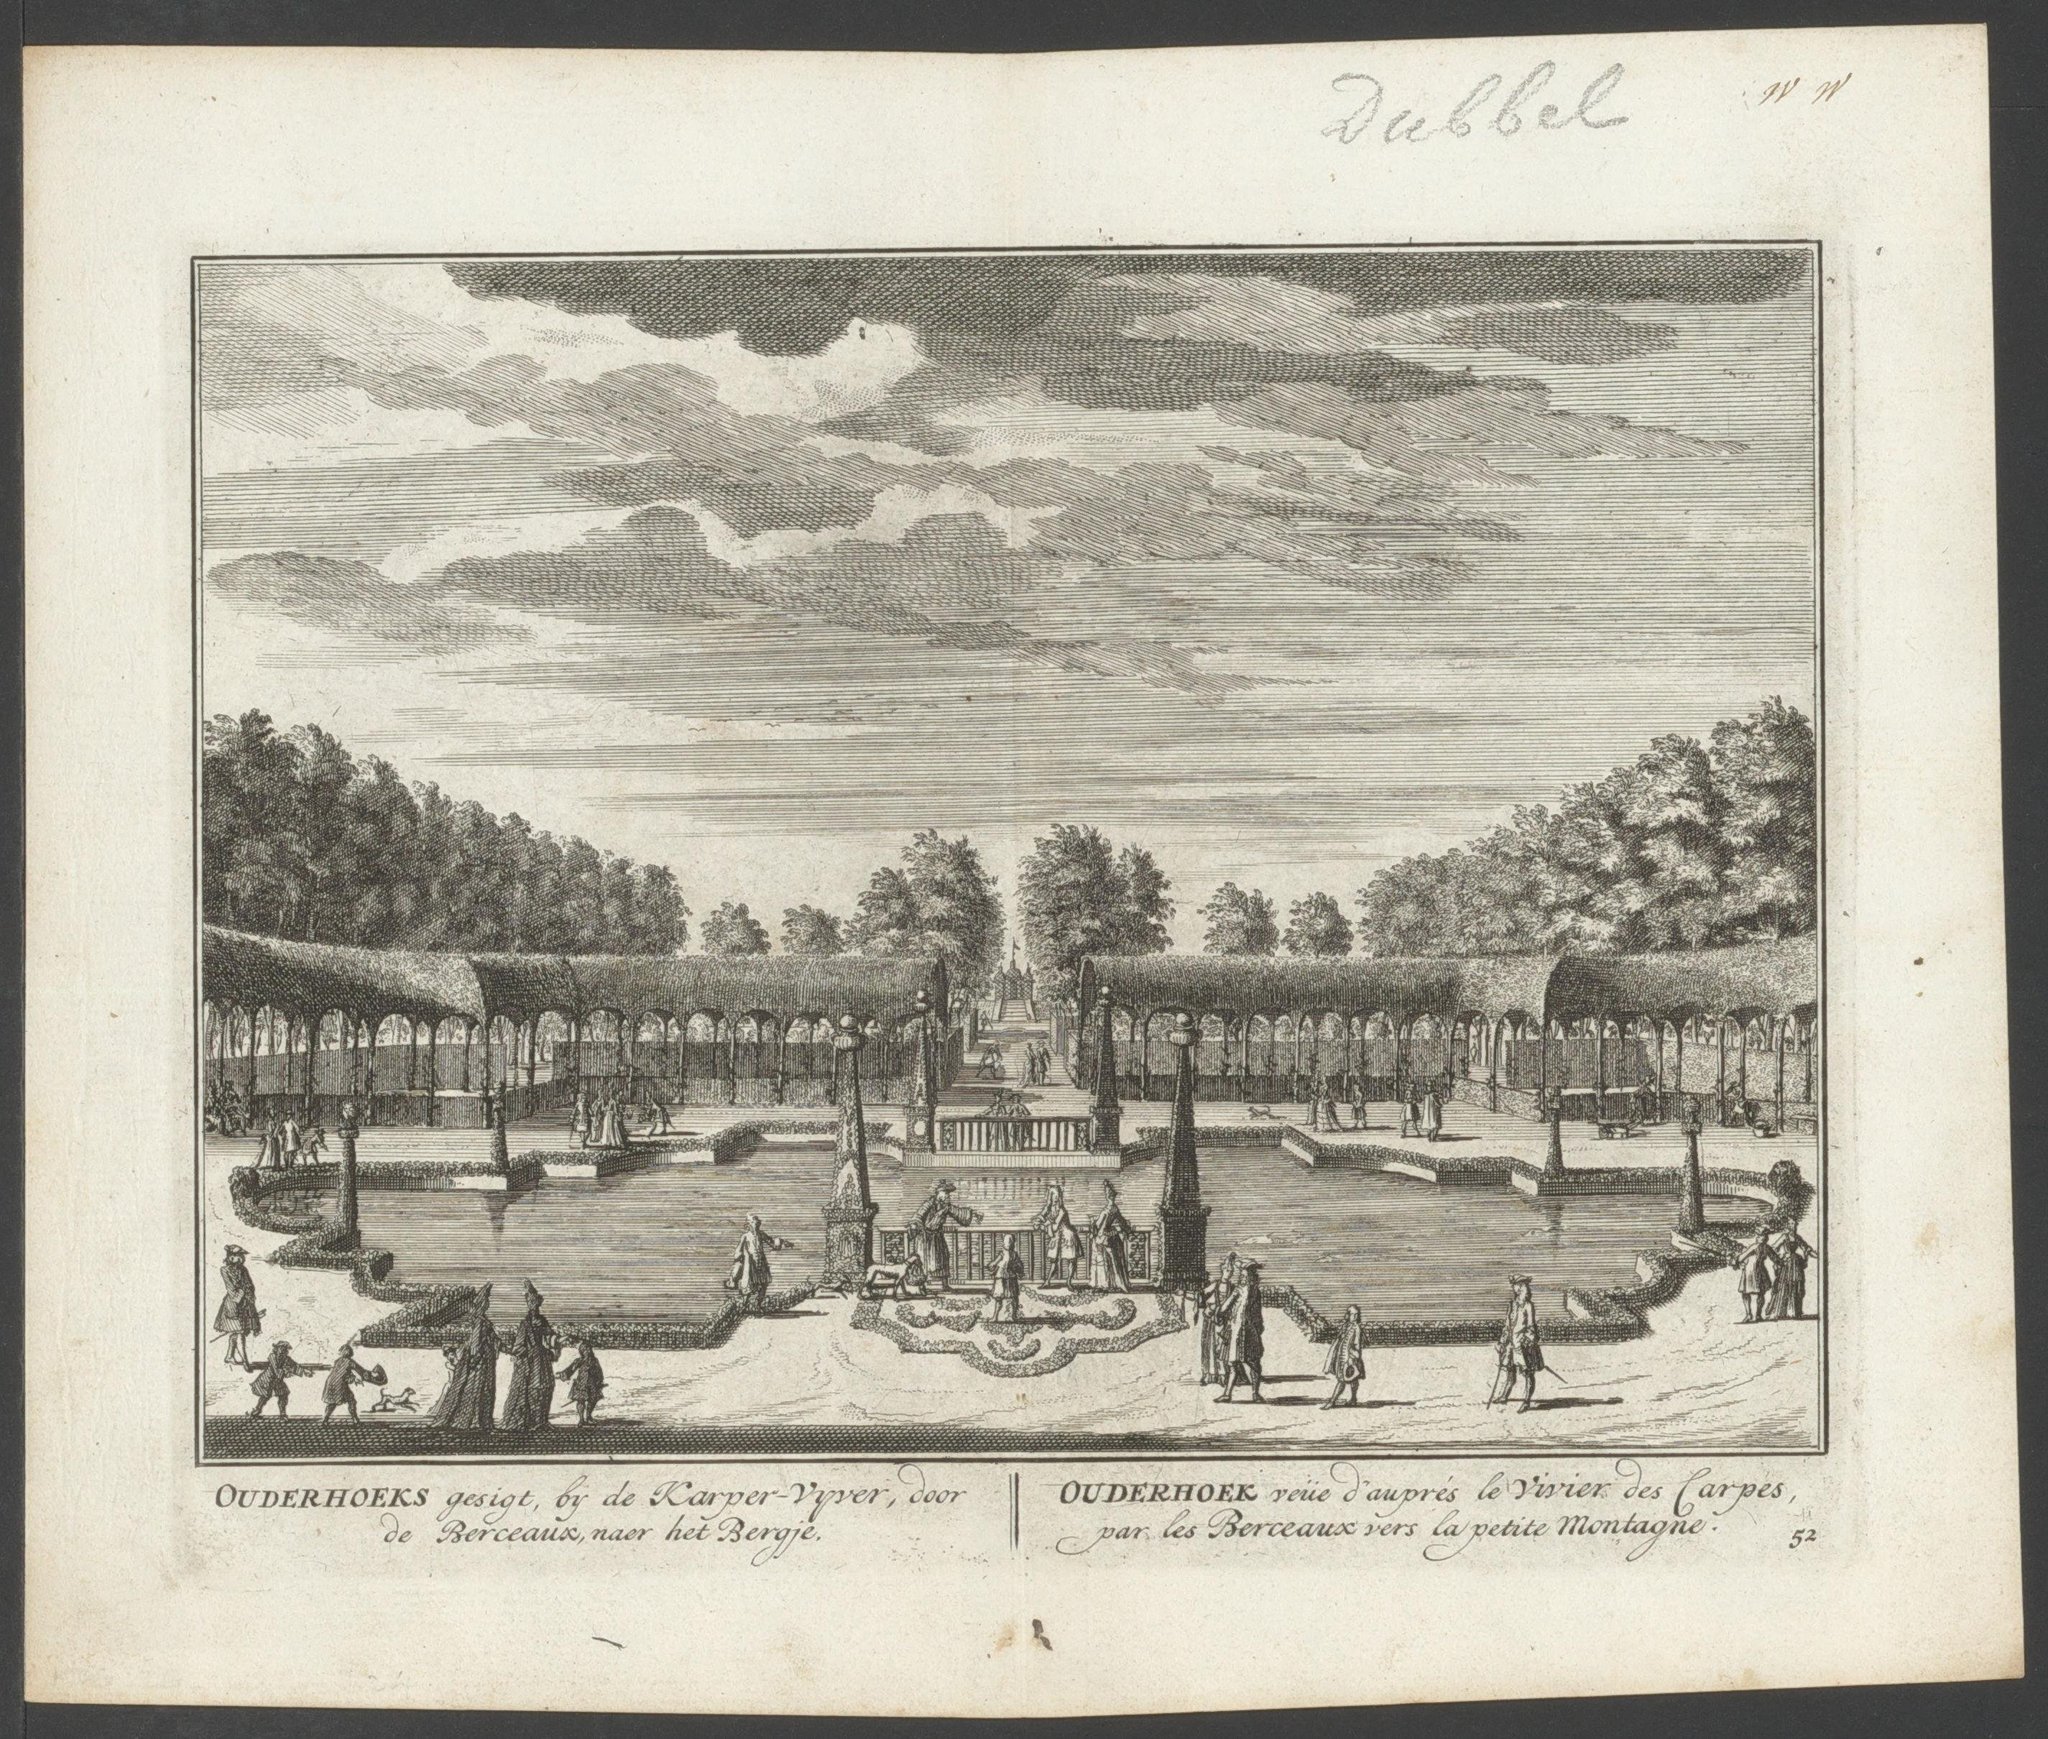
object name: print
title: Gezicht op de karpervijver van huis Ouderhoek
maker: daniël stopendaal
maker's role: print maker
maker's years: 1672-1726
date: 1719-1790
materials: paper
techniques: engraving, etching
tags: fish pond (in garden), rural housing, e.g. country-house, villa, cottage, french or architectonic garden; formal garden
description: Prent voor het eerst gebruikt in: Leth, Andries de. De zegepraalende Vecht, vertoonende verscheidene gesichten van lustplaatsen, heeren huysen en dorpen, beginnende van Uitrecht en met Muyden besluytende (...). Amsterdam: Weduwe Nicolaus Visscher, 1719. Prent mogelijk uit: Brouërius van Nidek, Matthaeus. De Vechtstroom, van Utrecht tot Muiden (...). Amsterdam: H. Gartman, W. Vermandel en J.W. Smit, 1790.